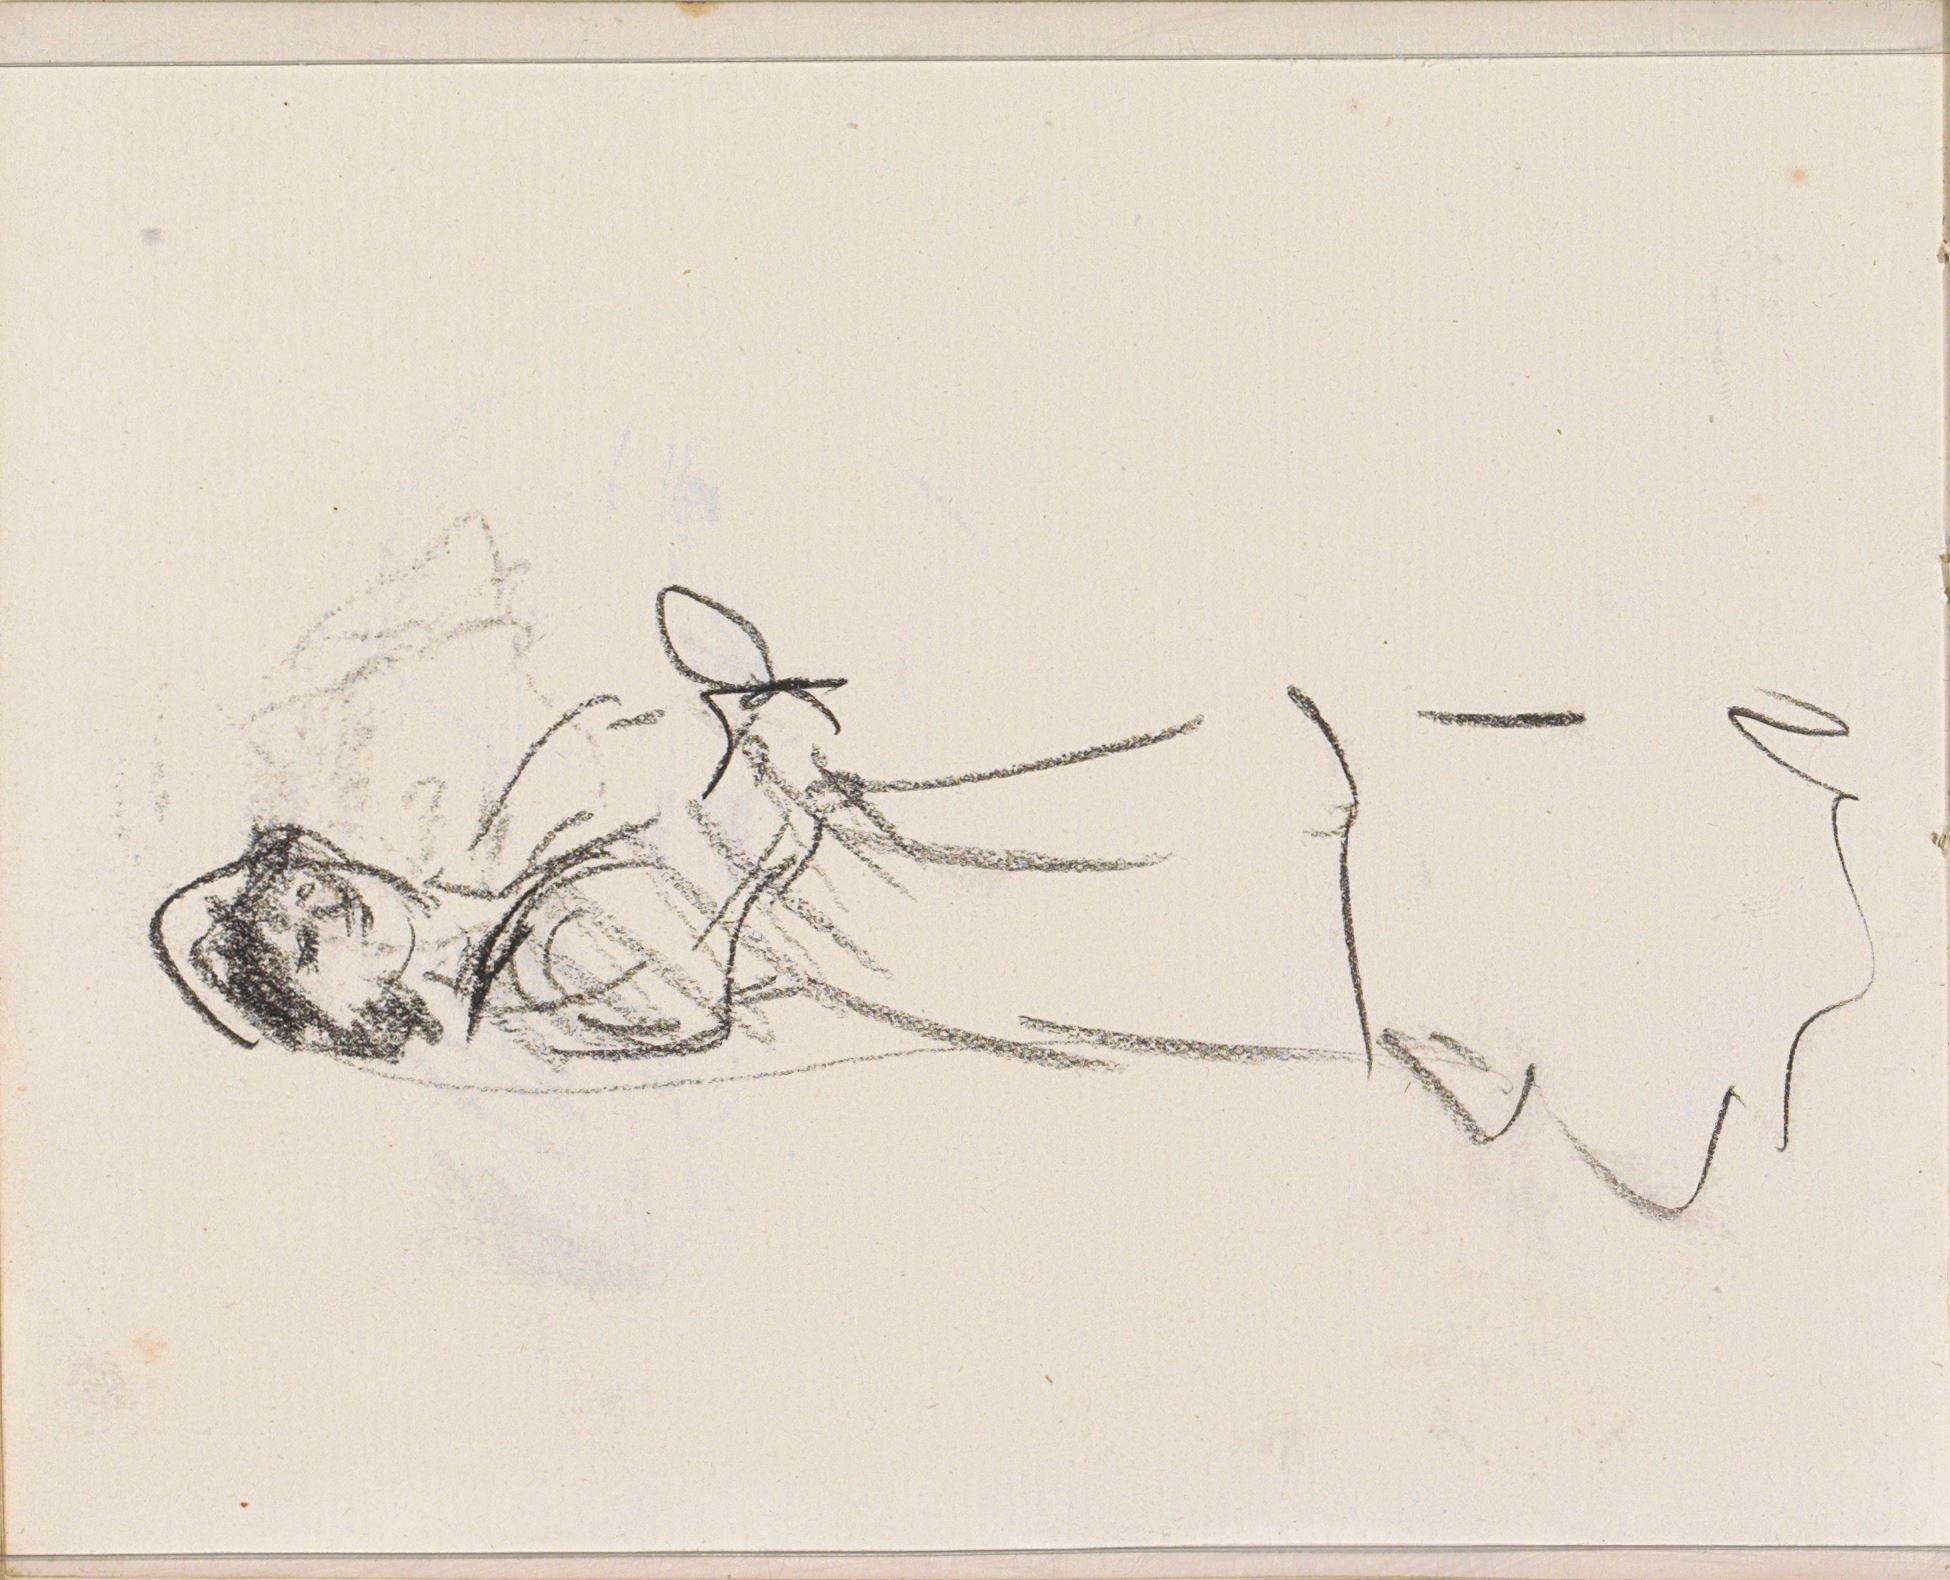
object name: sketchbook leaf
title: Staande vrouw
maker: isaac israels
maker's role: draughtsman, painter, print maker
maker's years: 1865-1934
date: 1875-1934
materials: chalk, paper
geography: the hague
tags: adult woman (+ standing)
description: Pagina 31 uit schetsboek XLIII met 61 pagina's.